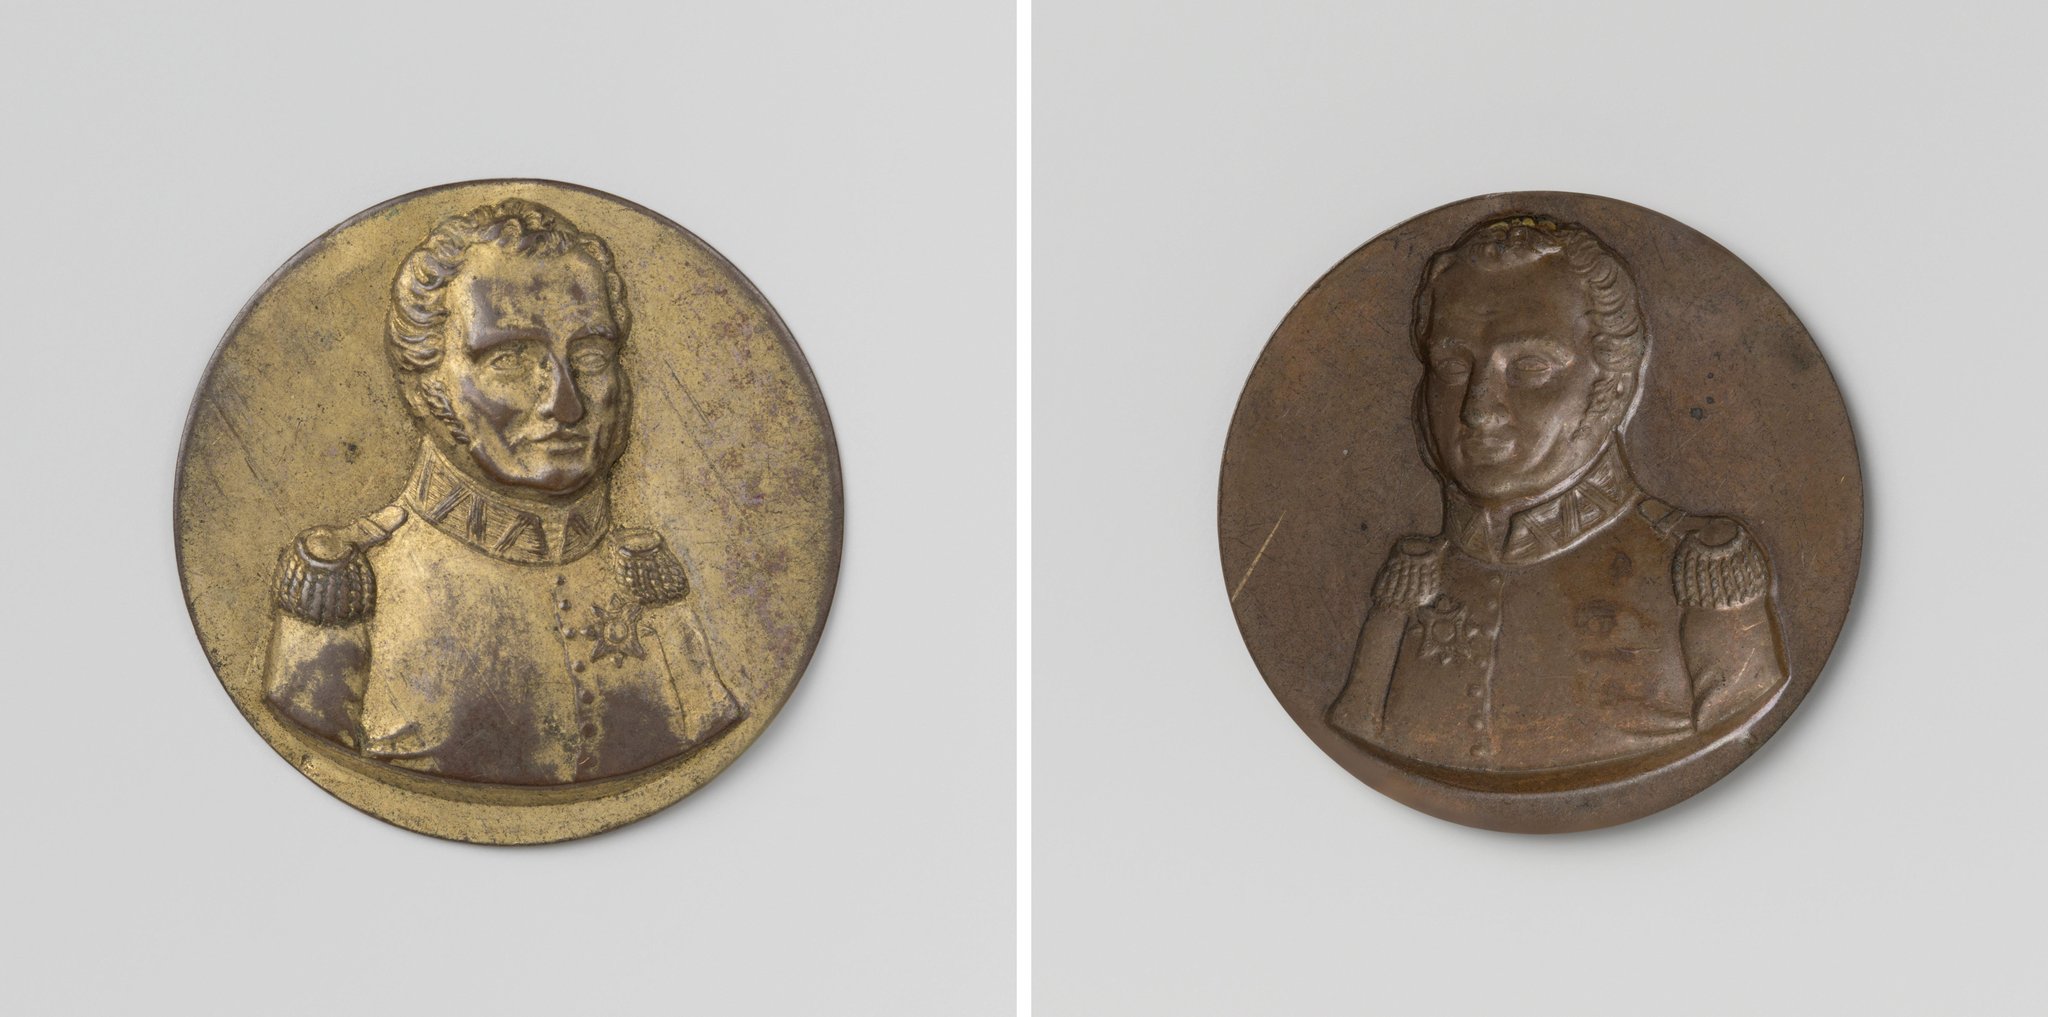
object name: plate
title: Willem I, koning der Nederlanden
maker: Anonymous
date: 1815-1843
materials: copper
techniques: gilding, striking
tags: the hague, berlin, william i of the netherlands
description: eenzijdig plaatje. Voorzijde: borststuk man naar rechts. Keerzijde: blanco